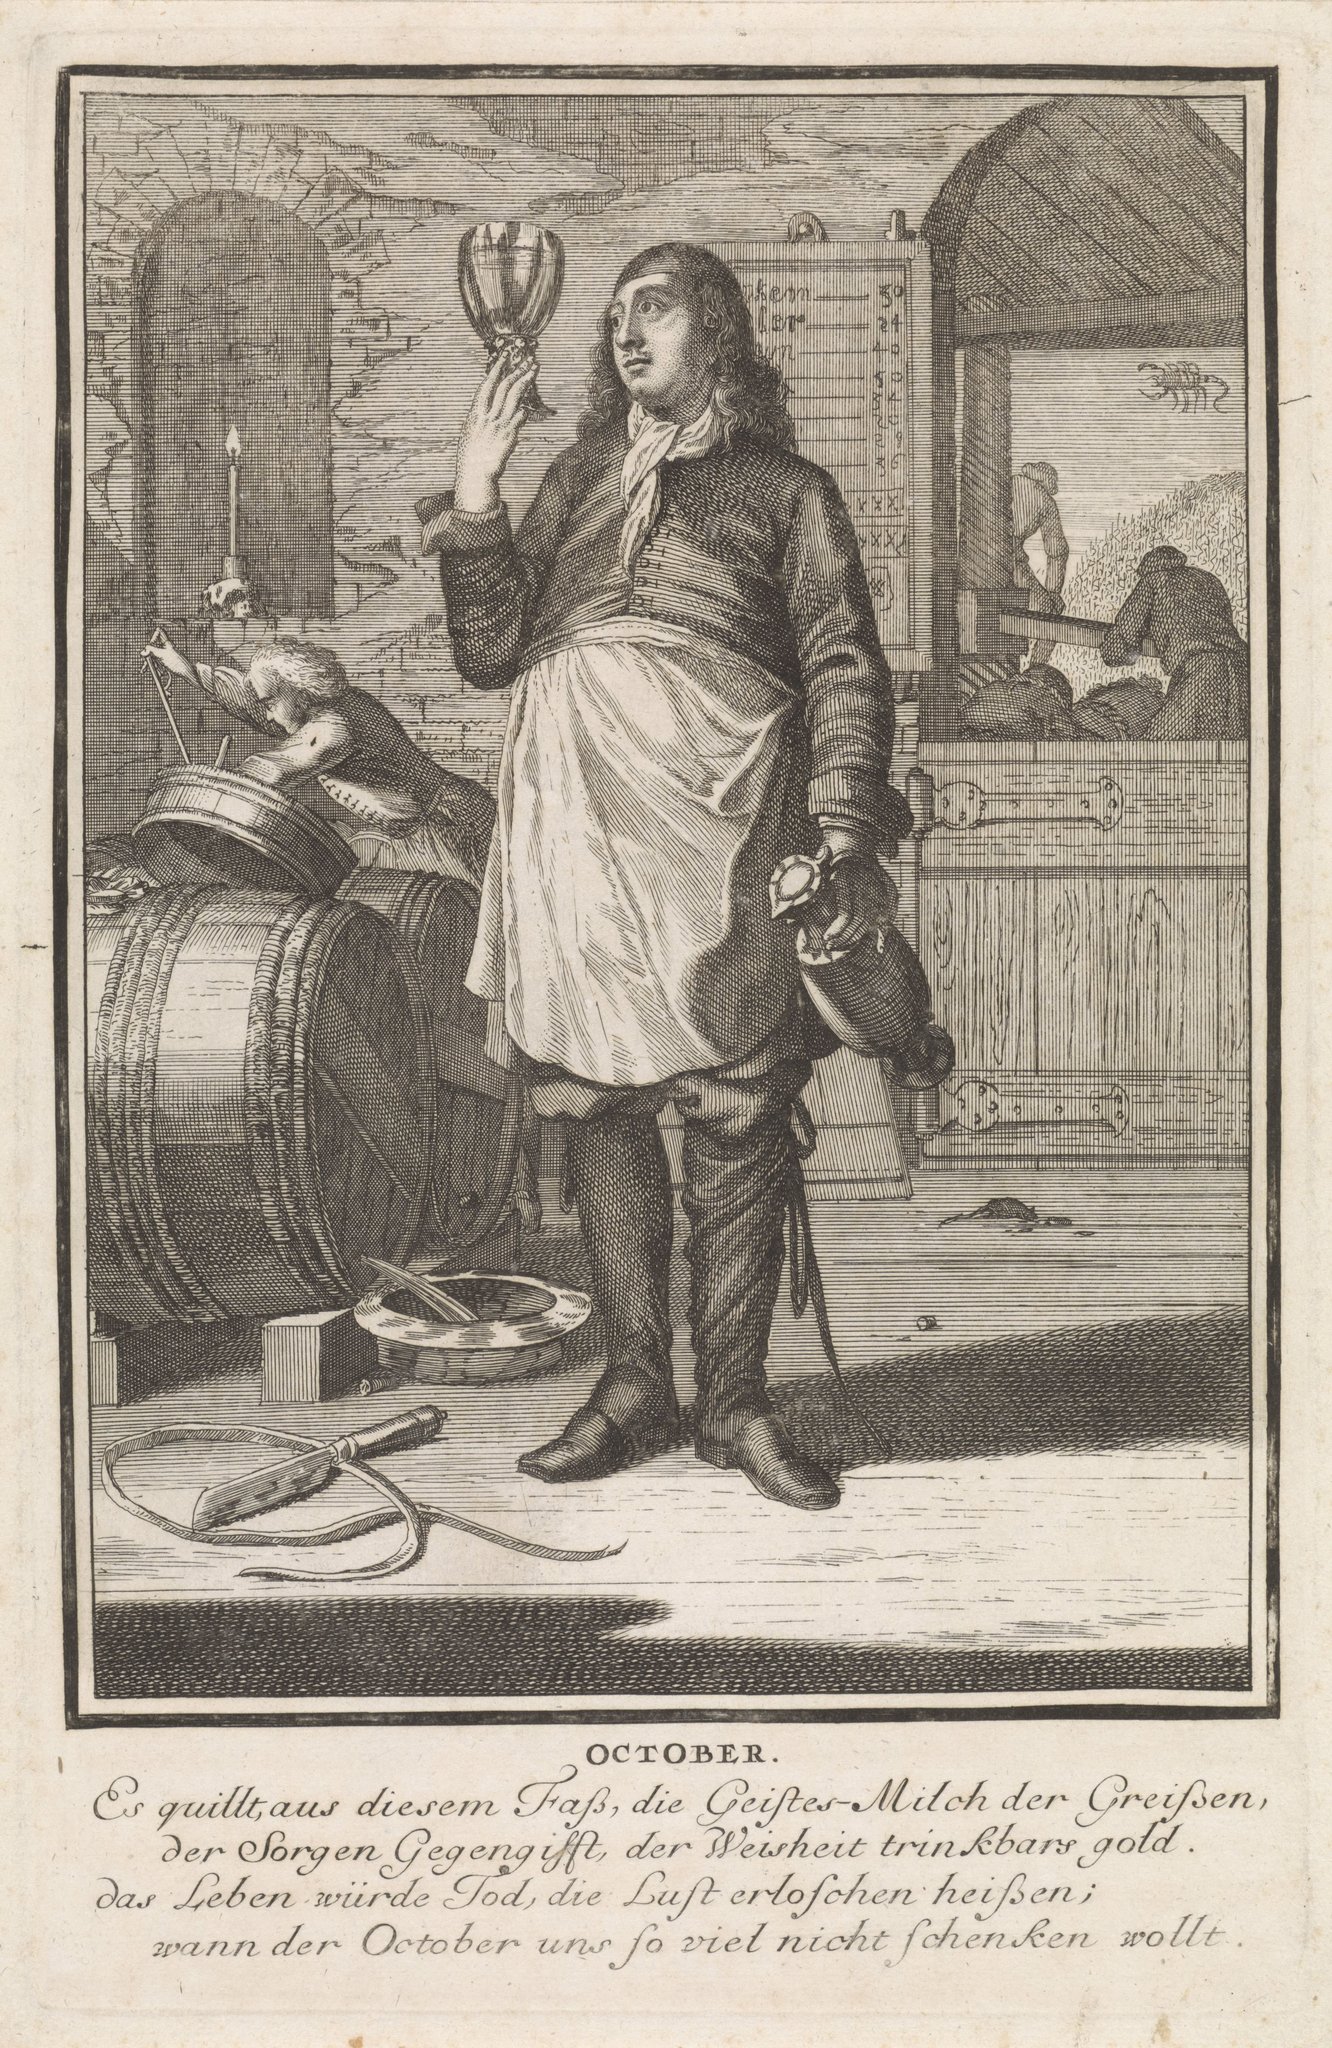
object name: print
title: De twaalf maanden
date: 1698-1702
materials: paper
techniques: engraving, etching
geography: nuremberg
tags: wine-vault, 'cave', landscape symbolizing october, october; 'ottobre' (ripa), wooden container: barrel, cask, bucket, october and its 'labours', scorpio (zodiacal sign of october), vintage, grape harvest, hotel, hostelry, inn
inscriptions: collector's mark: Lugt 2228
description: De maand oktober. Op de voorgrond kijkt een waard naar een glazen beker in zijn hand. Naast hem worden vaten gekuipt. Op de achtergrond worden druiven geplukt en wordt er wijn gemaakt. De prent heeft een Duits onderschrift van vier regels over de maand oktober.